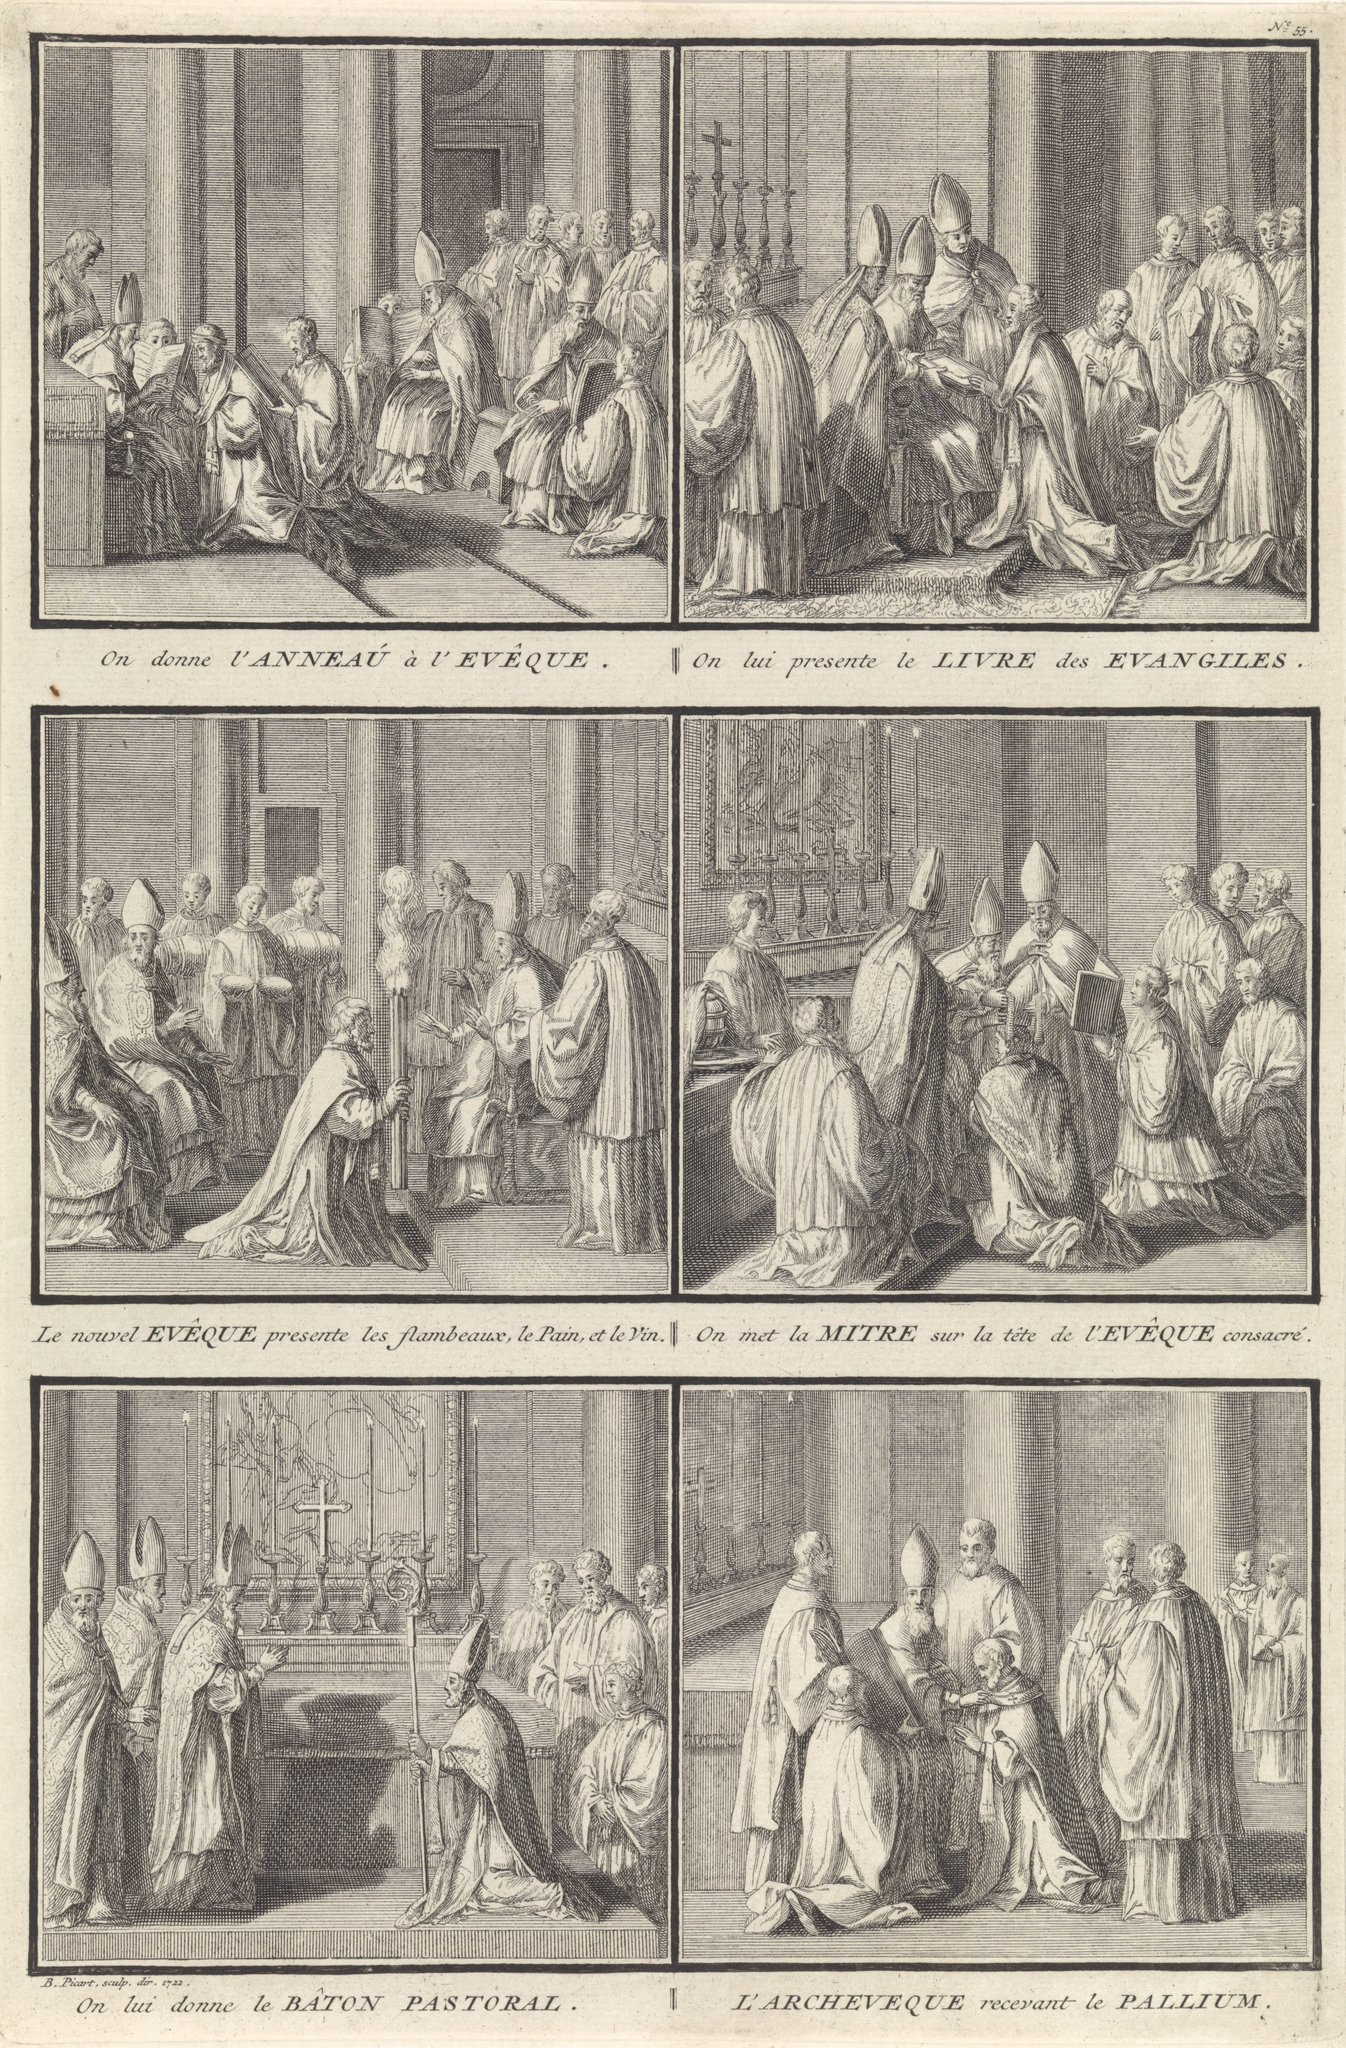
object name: print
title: Wijding van bisschoppen en aartsbisschoppen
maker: bernard picart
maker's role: draughtsman, print maker, publisher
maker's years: 1673-1733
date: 1722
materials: paper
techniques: engraving, etching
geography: amsterdam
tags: archbishop, bishop, etc. (roman catholic), inauguration, consecration of person(s) ~ church, insignia of bishop, e.g. mitre, crozier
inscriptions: collector's mark: Lugt 2233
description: Blad met zes voorstellingen van het wijden van bisschoppen in de rooms-katholieke kerk. Linksboven: De pas gewijde bisschop ontvangt de bisschopsring. Rechtsboven: Het Evangelieboek wordt de nieuwe bisschop aangeboden. Links midden: De nieuwe bisschop pntvangt brandende kaarsen. Rechts midden: De nieuwe bisschop ontvangt de bisschopsmijter. Linksonder: De nieuwe bisschop ontvangt de bisschopsstaf. Rechtsonder: Een nieuwe aartsbisschop ontvangt het pallium. Rechtsboven genummerd: No. 55.